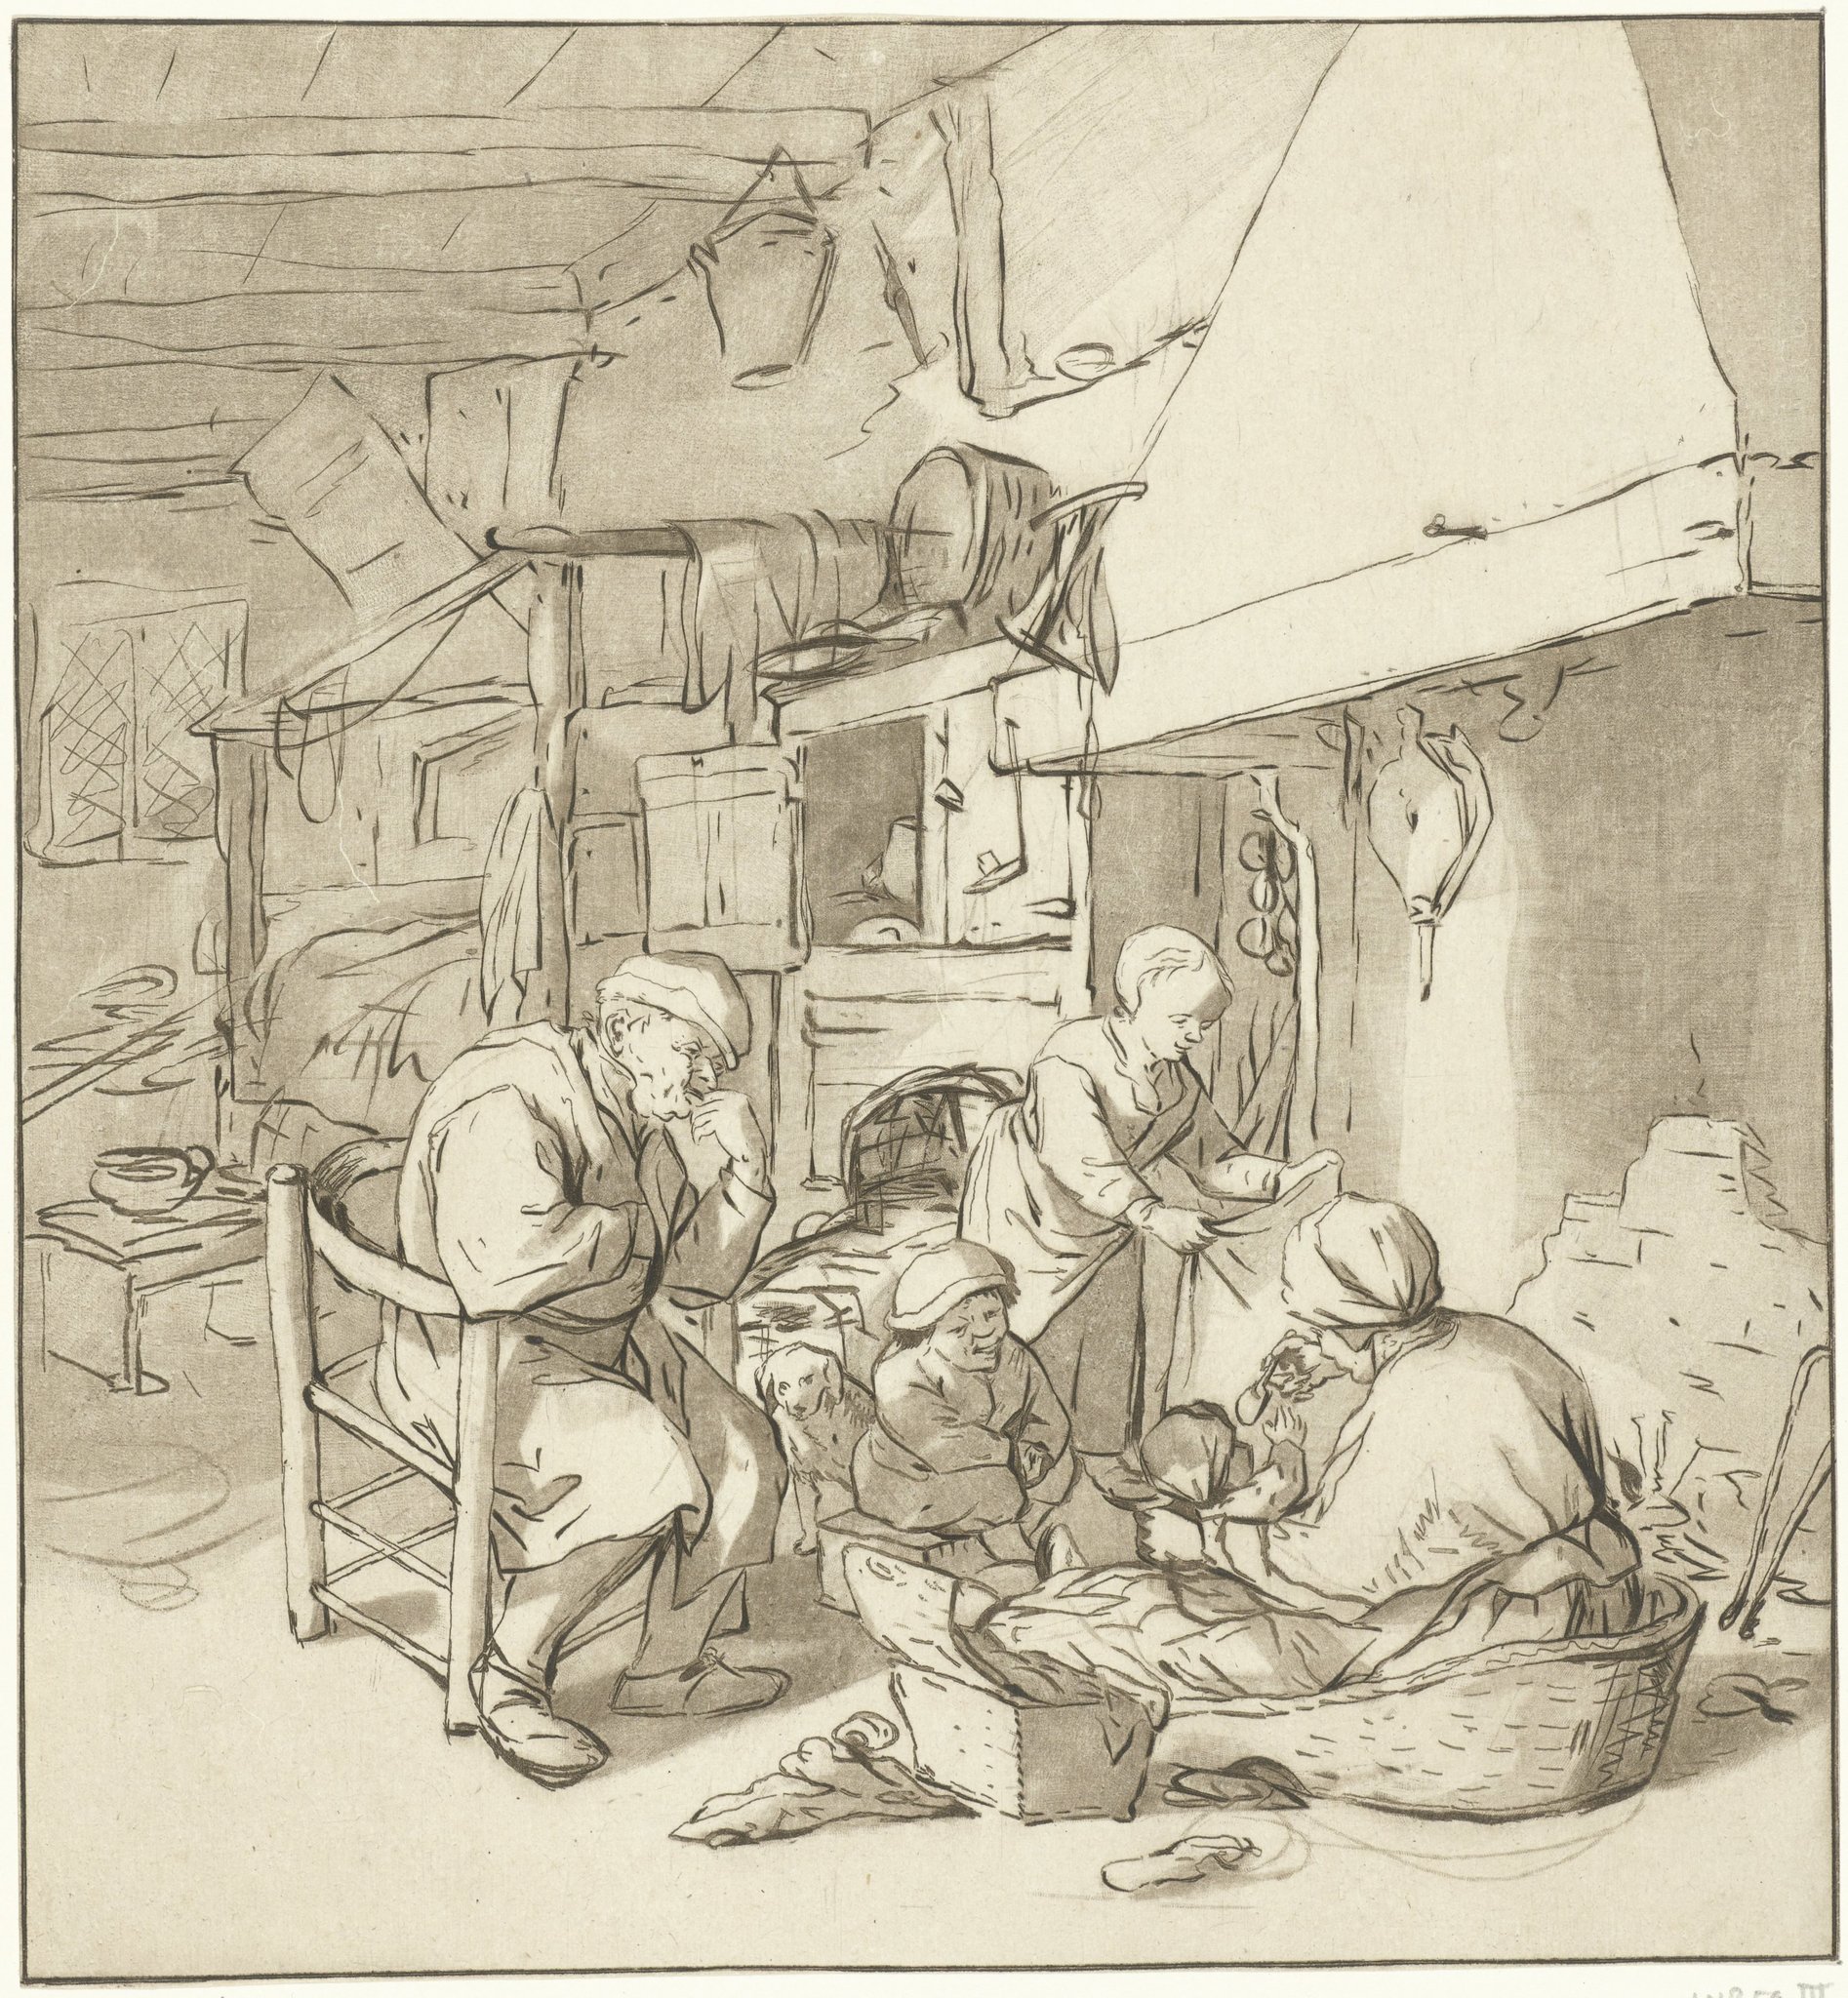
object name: print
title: Boerengezin bij schoorsteen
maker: cornelis ploos van amstel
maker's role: draughtsman, print maker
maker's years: 1726-1798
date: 1767-1821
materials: paper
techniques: etching, roulette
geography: amsterdam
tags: open hearth, fire-place, interior of the house, family life at home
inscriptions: collector's mark: Lugt 240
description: Interieur met een gezin rond de schoorsteen. Een moeder voedt haar baby.